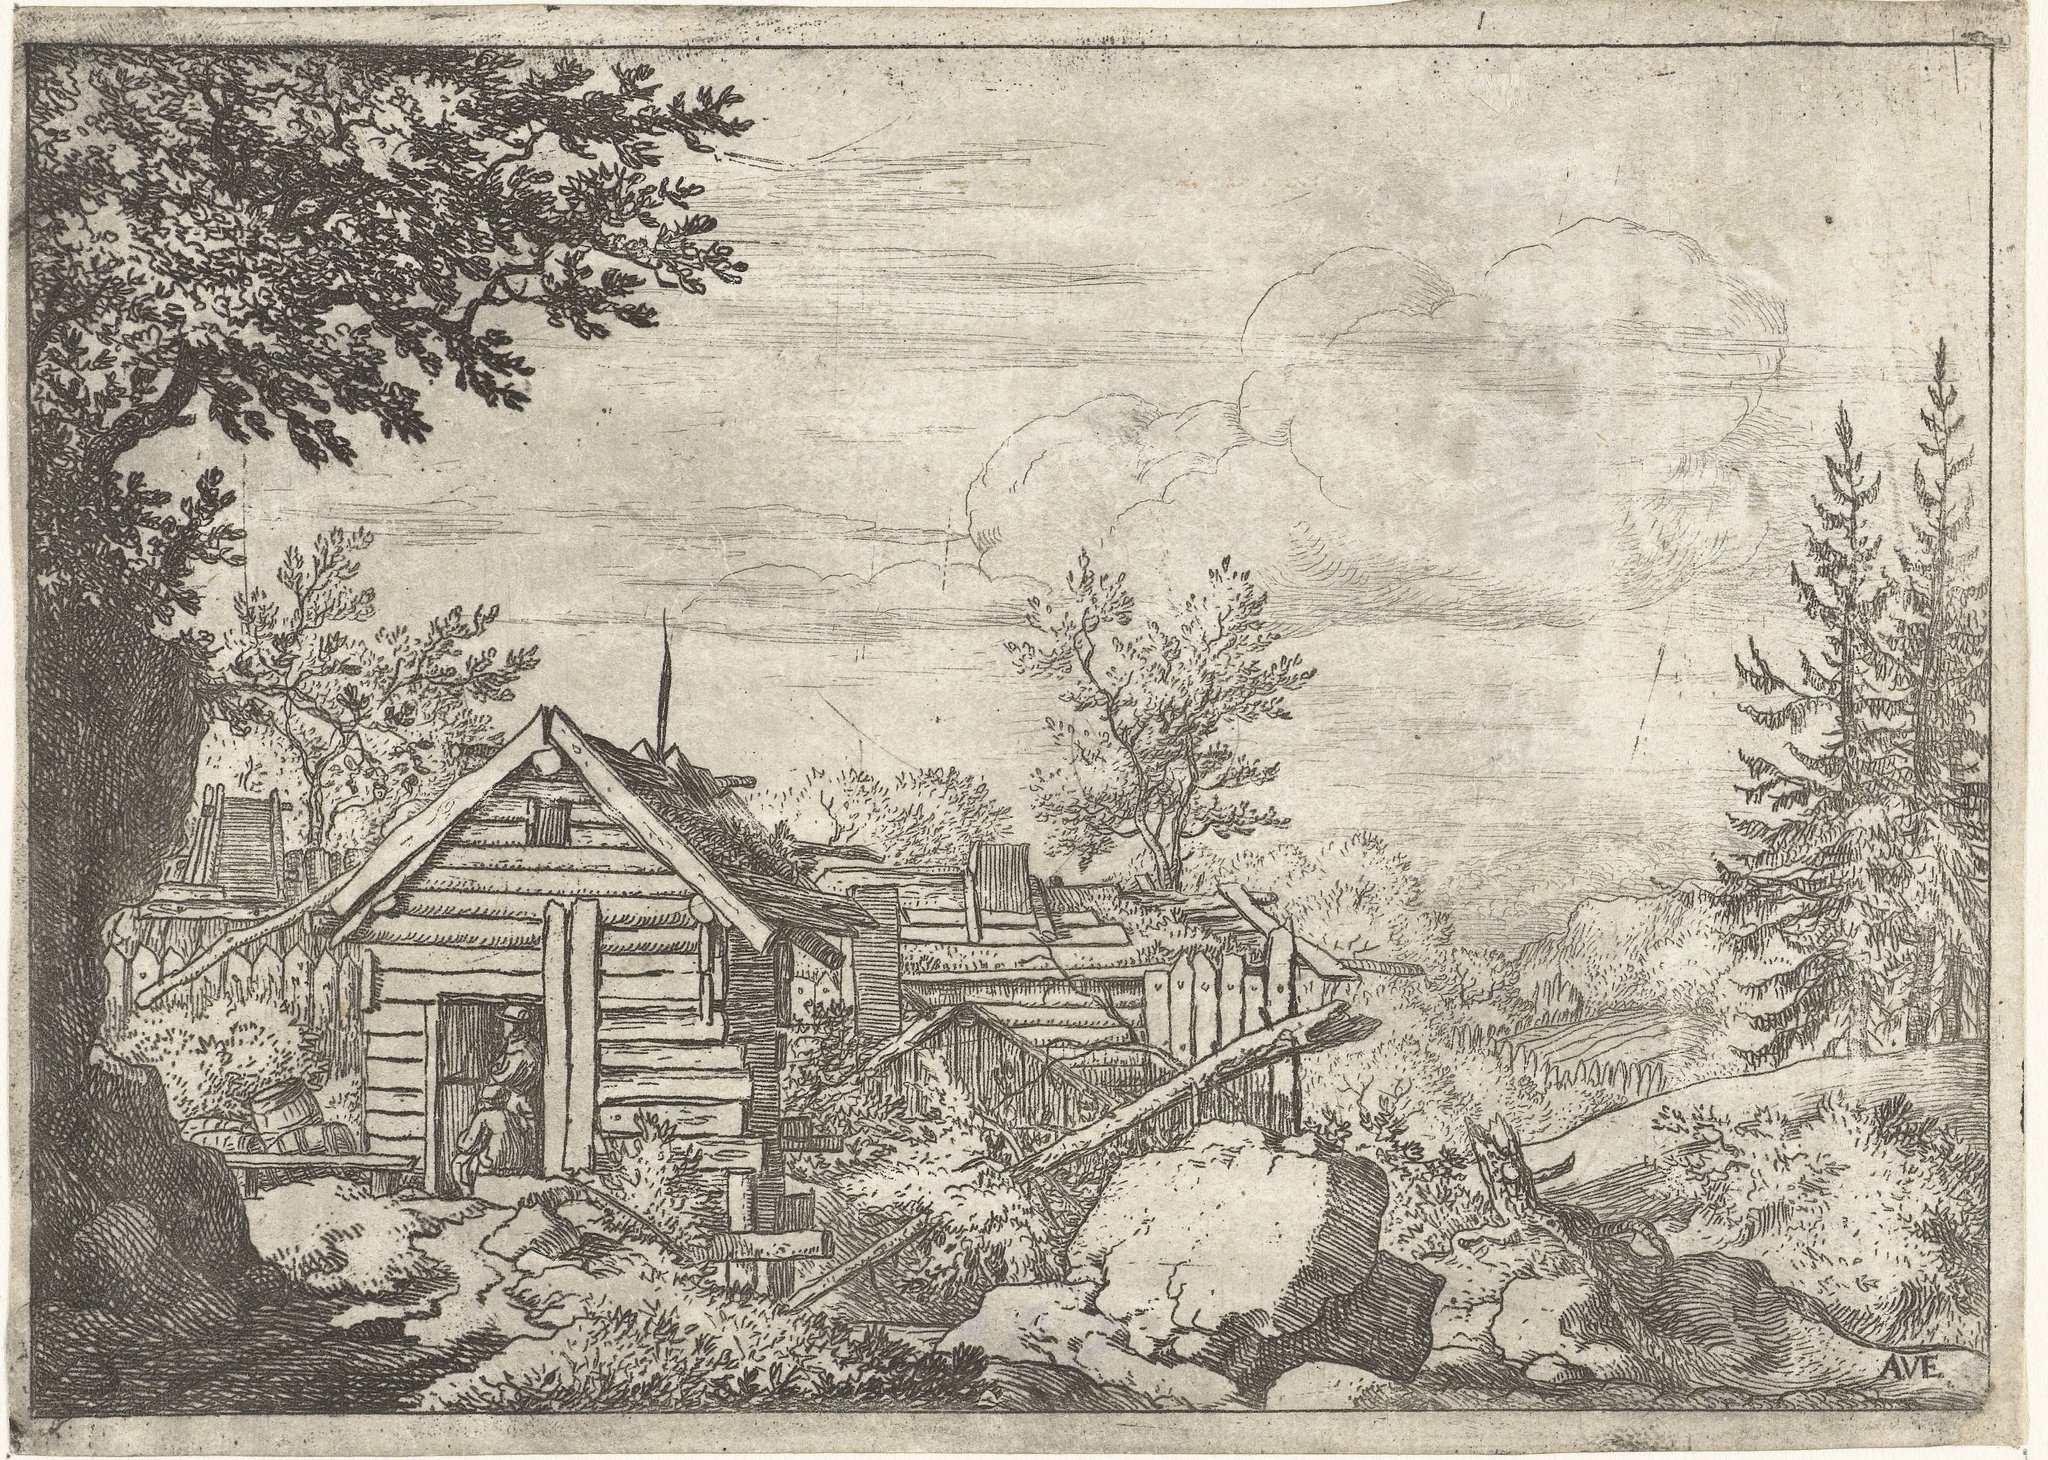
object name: print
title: Landschap met twee mannen in de deuropening van een houten hut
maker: allaert van everdingen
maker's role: draughtsman, painter, print maker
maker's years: 1621-1675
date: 1631-1675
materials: paper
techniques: etching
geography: netherlands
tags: farm or solitary house in landscape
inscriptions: collector's mark: Lugt 2228